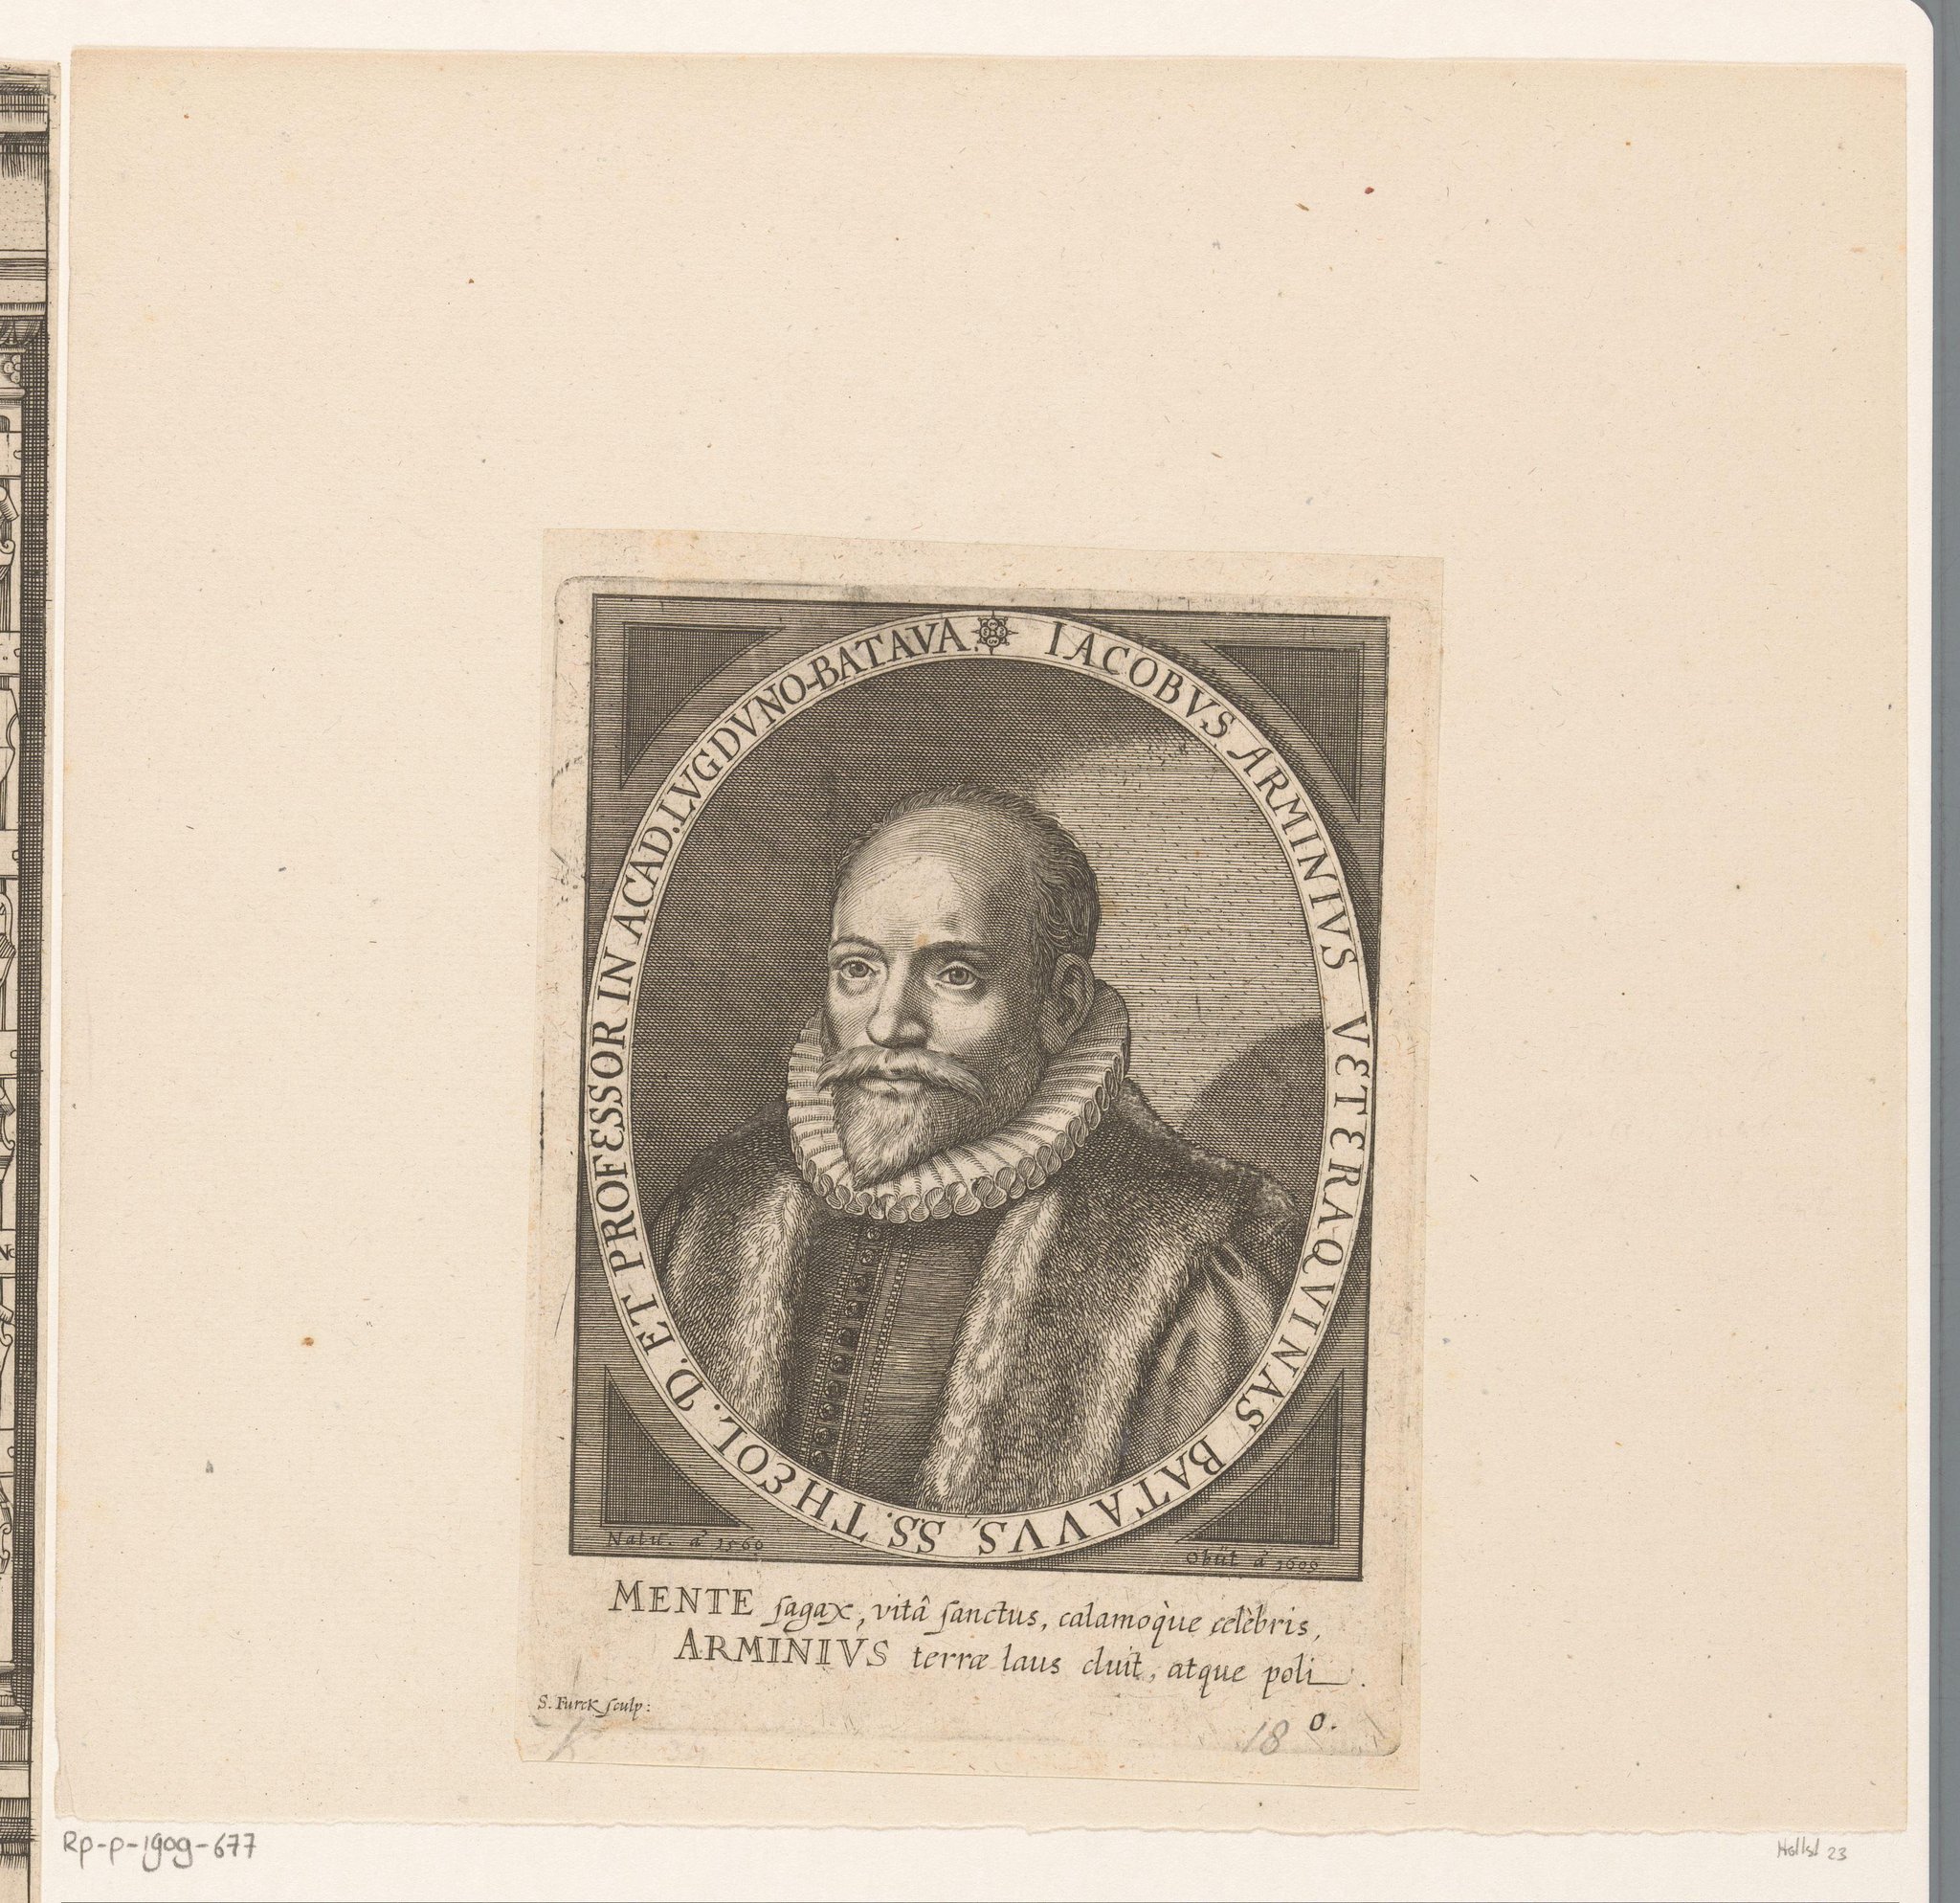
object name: print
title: Portret van Jakob Arminius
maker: sebastian furck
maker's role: print maker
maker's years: 1600-1655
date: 1610-1655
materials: paper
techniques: engraving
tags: leiden, theologian, historical persons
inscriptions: collector's mark: Lugt 2228